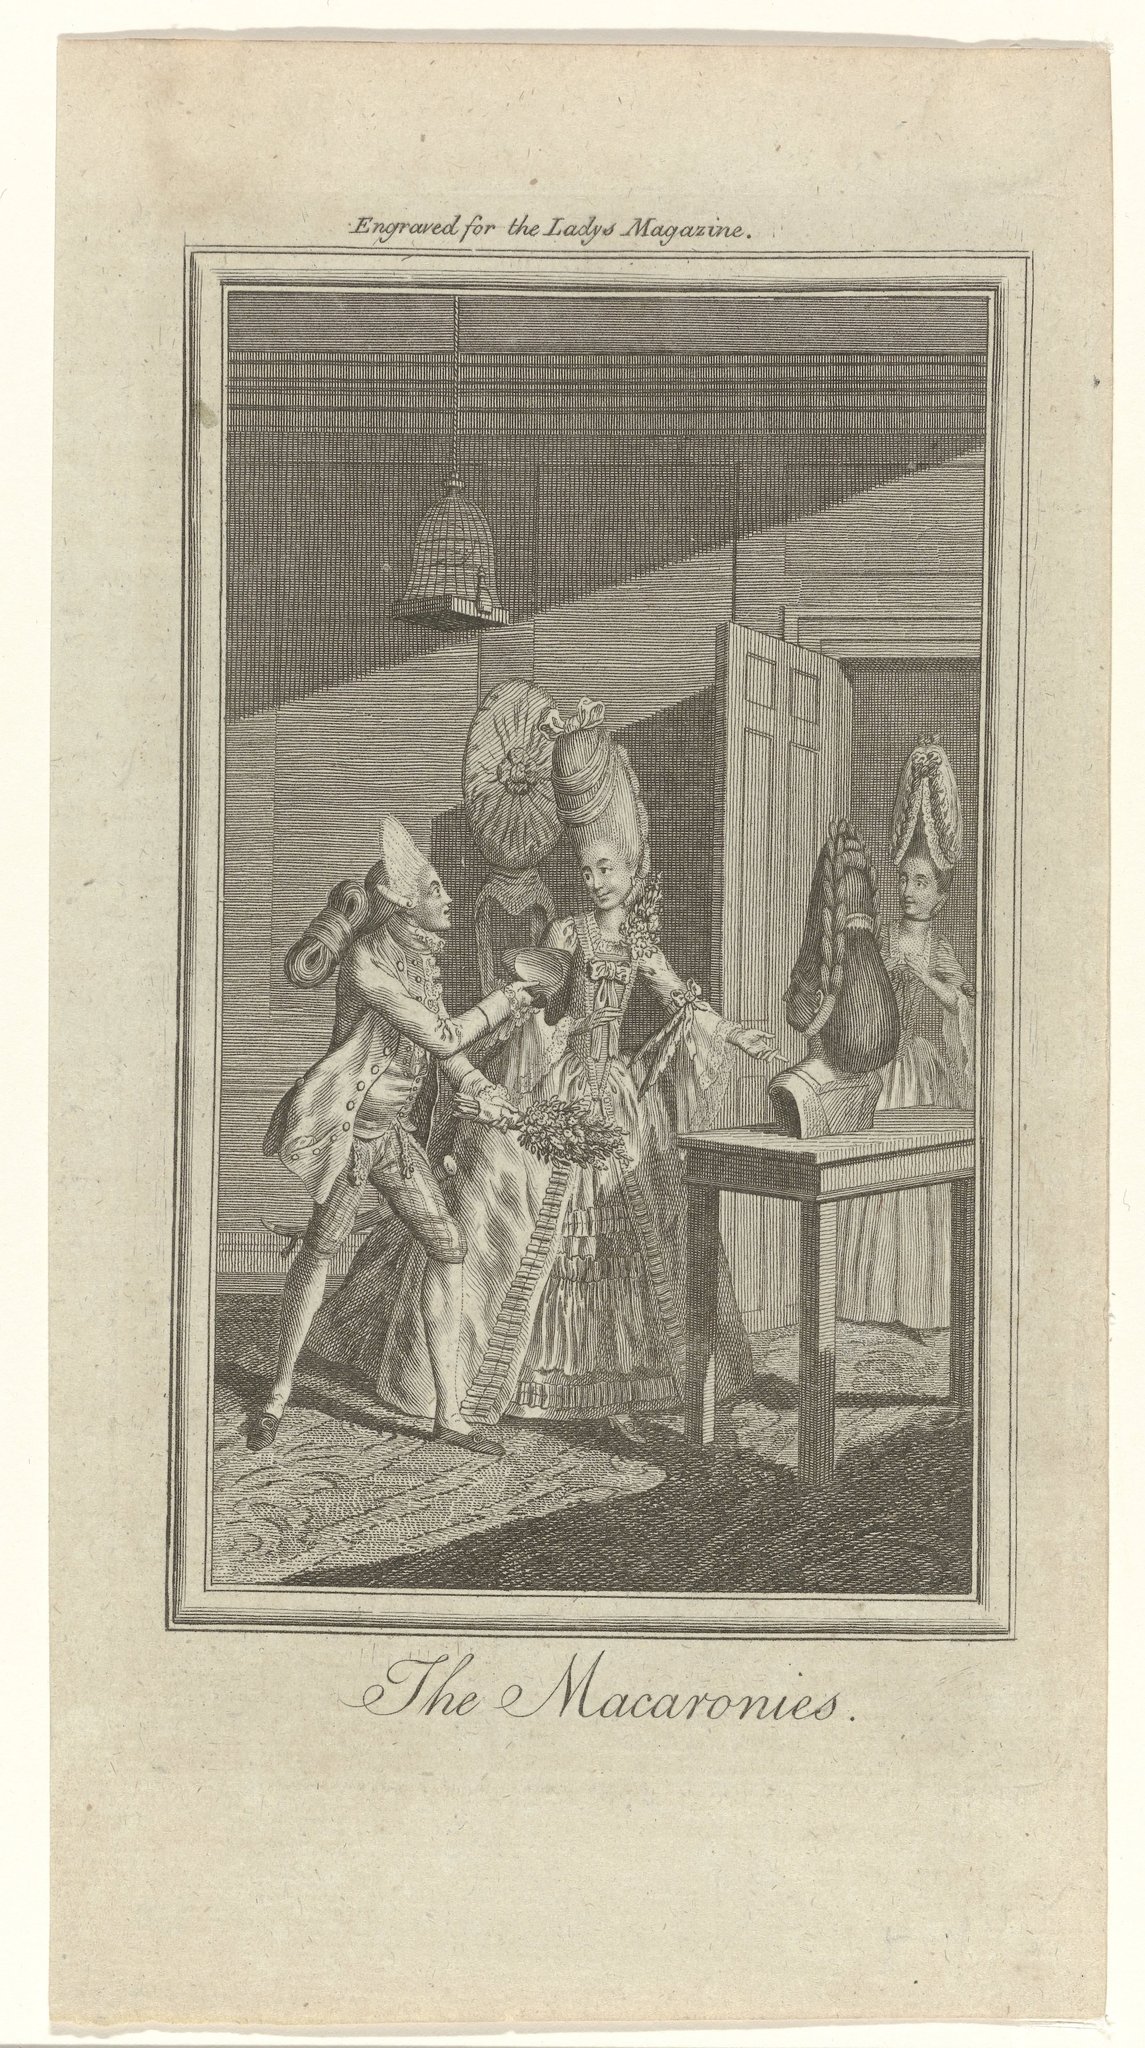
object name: cartoon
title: Staande man en twee vrouwen in een interieur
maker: Anonymous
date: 1770-1775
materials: paper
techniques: engraving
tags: corsage (+ women's clothes), clothing for the upper part of the body (vest) (+ men's clothes), cut flowers; nosegay, bunch of flowers, wig - aa - ~ women, coat (frac) (+ men's clothes), head-gear: cap (+ women's clothes), fashion plates, clothes, costume (+ women's clothes), dress, gown (+ women's clothes), clothes, costume (+ men's clothes), interior of the house, wig, trousers, breeches, etc. (breeches) (+ men's clothes)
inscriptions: title: ‘The Macaronies.’, inscription: ‘Engraved for the Ladys Magazine’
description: 'Macaroni' met hoed en boeket in de handen, staand bij een vrouw in interieur met op de tafel een buste met in-folio pruik. Hij draagt een frak, vest, en een gestreepte kniebroek. Accessoires: breloques, degen, schoenen met gespen. De vrouw is gekleed in een japon met bloemcorsage en strikken, op een rok met aangerimpelde stroken. In de deuropening staat een vrouw met op het hoge kapsel een muts. Om de hals een zwart lint. De prent is gemaakt voor The Lady's Magazine, Londen, 1770-1837.